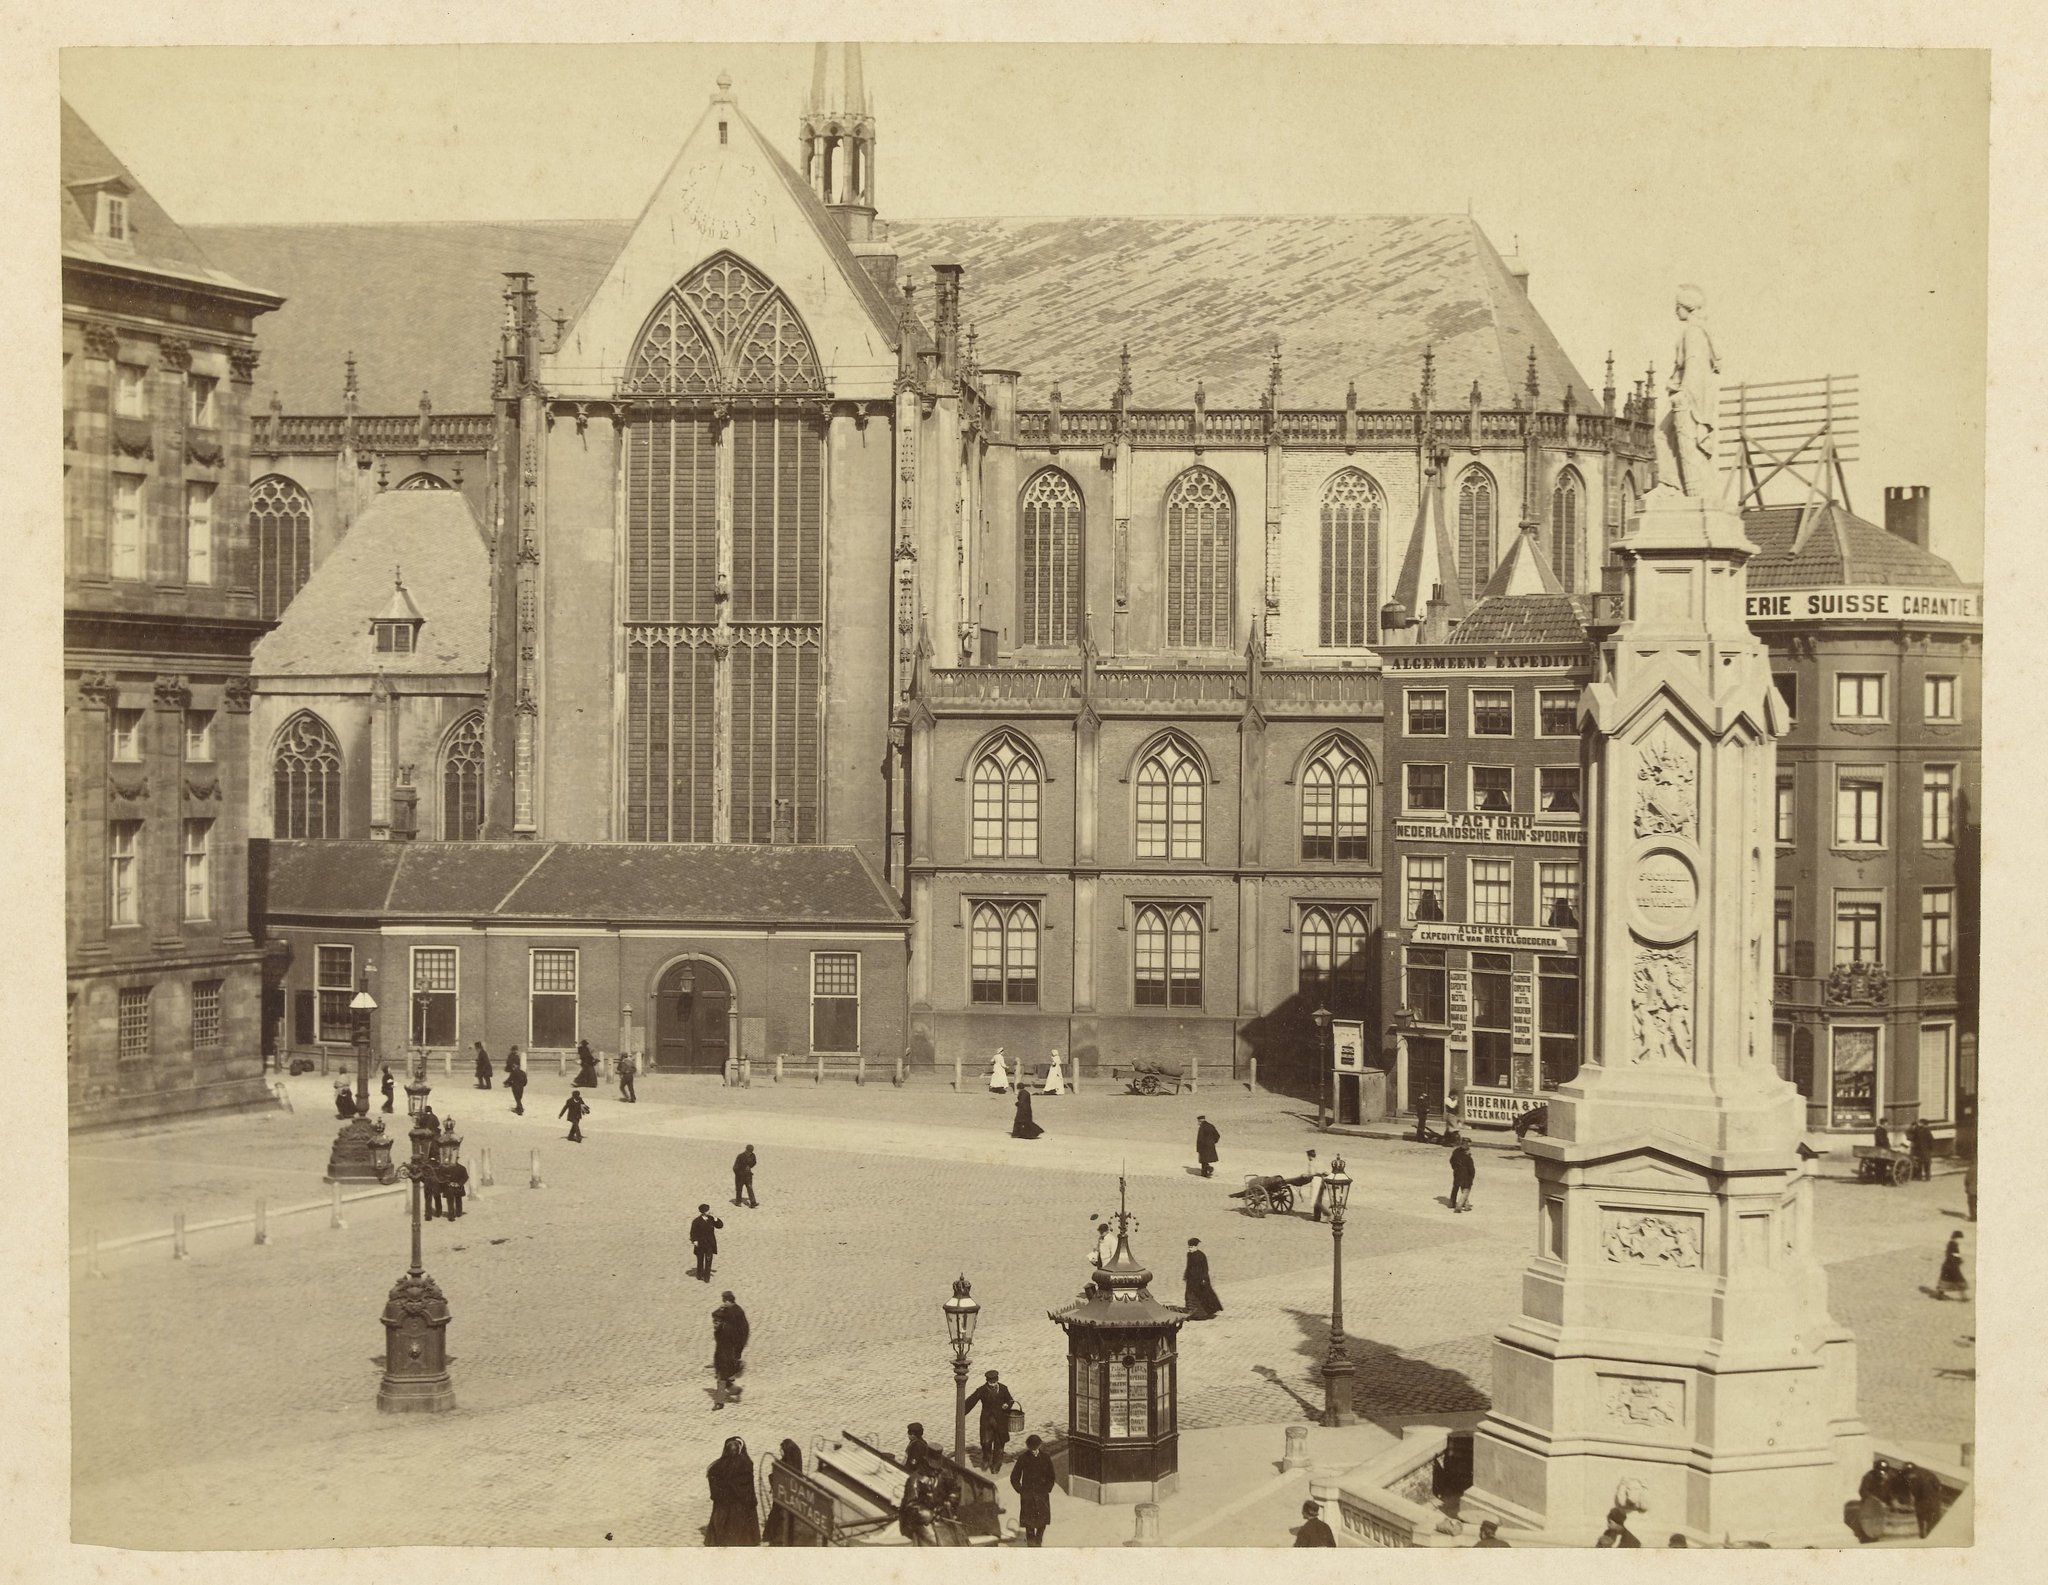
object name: photograph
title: Dam, Nieuwe Kerk en het monument Naatje te Amsterdam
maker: albert greiner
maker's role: fotograaf, fotostudio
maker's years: 1833-1890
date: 1875-1885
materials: cardboard, photographic support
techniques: albumen print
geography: amsterdam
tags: nieuwe kerk, dam, naatje op de dam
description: Dam, Nieuwe Kerk en Naatje (het Monument ter herinnering aan de Volksgeest van 1830-1831), Amsterdam.